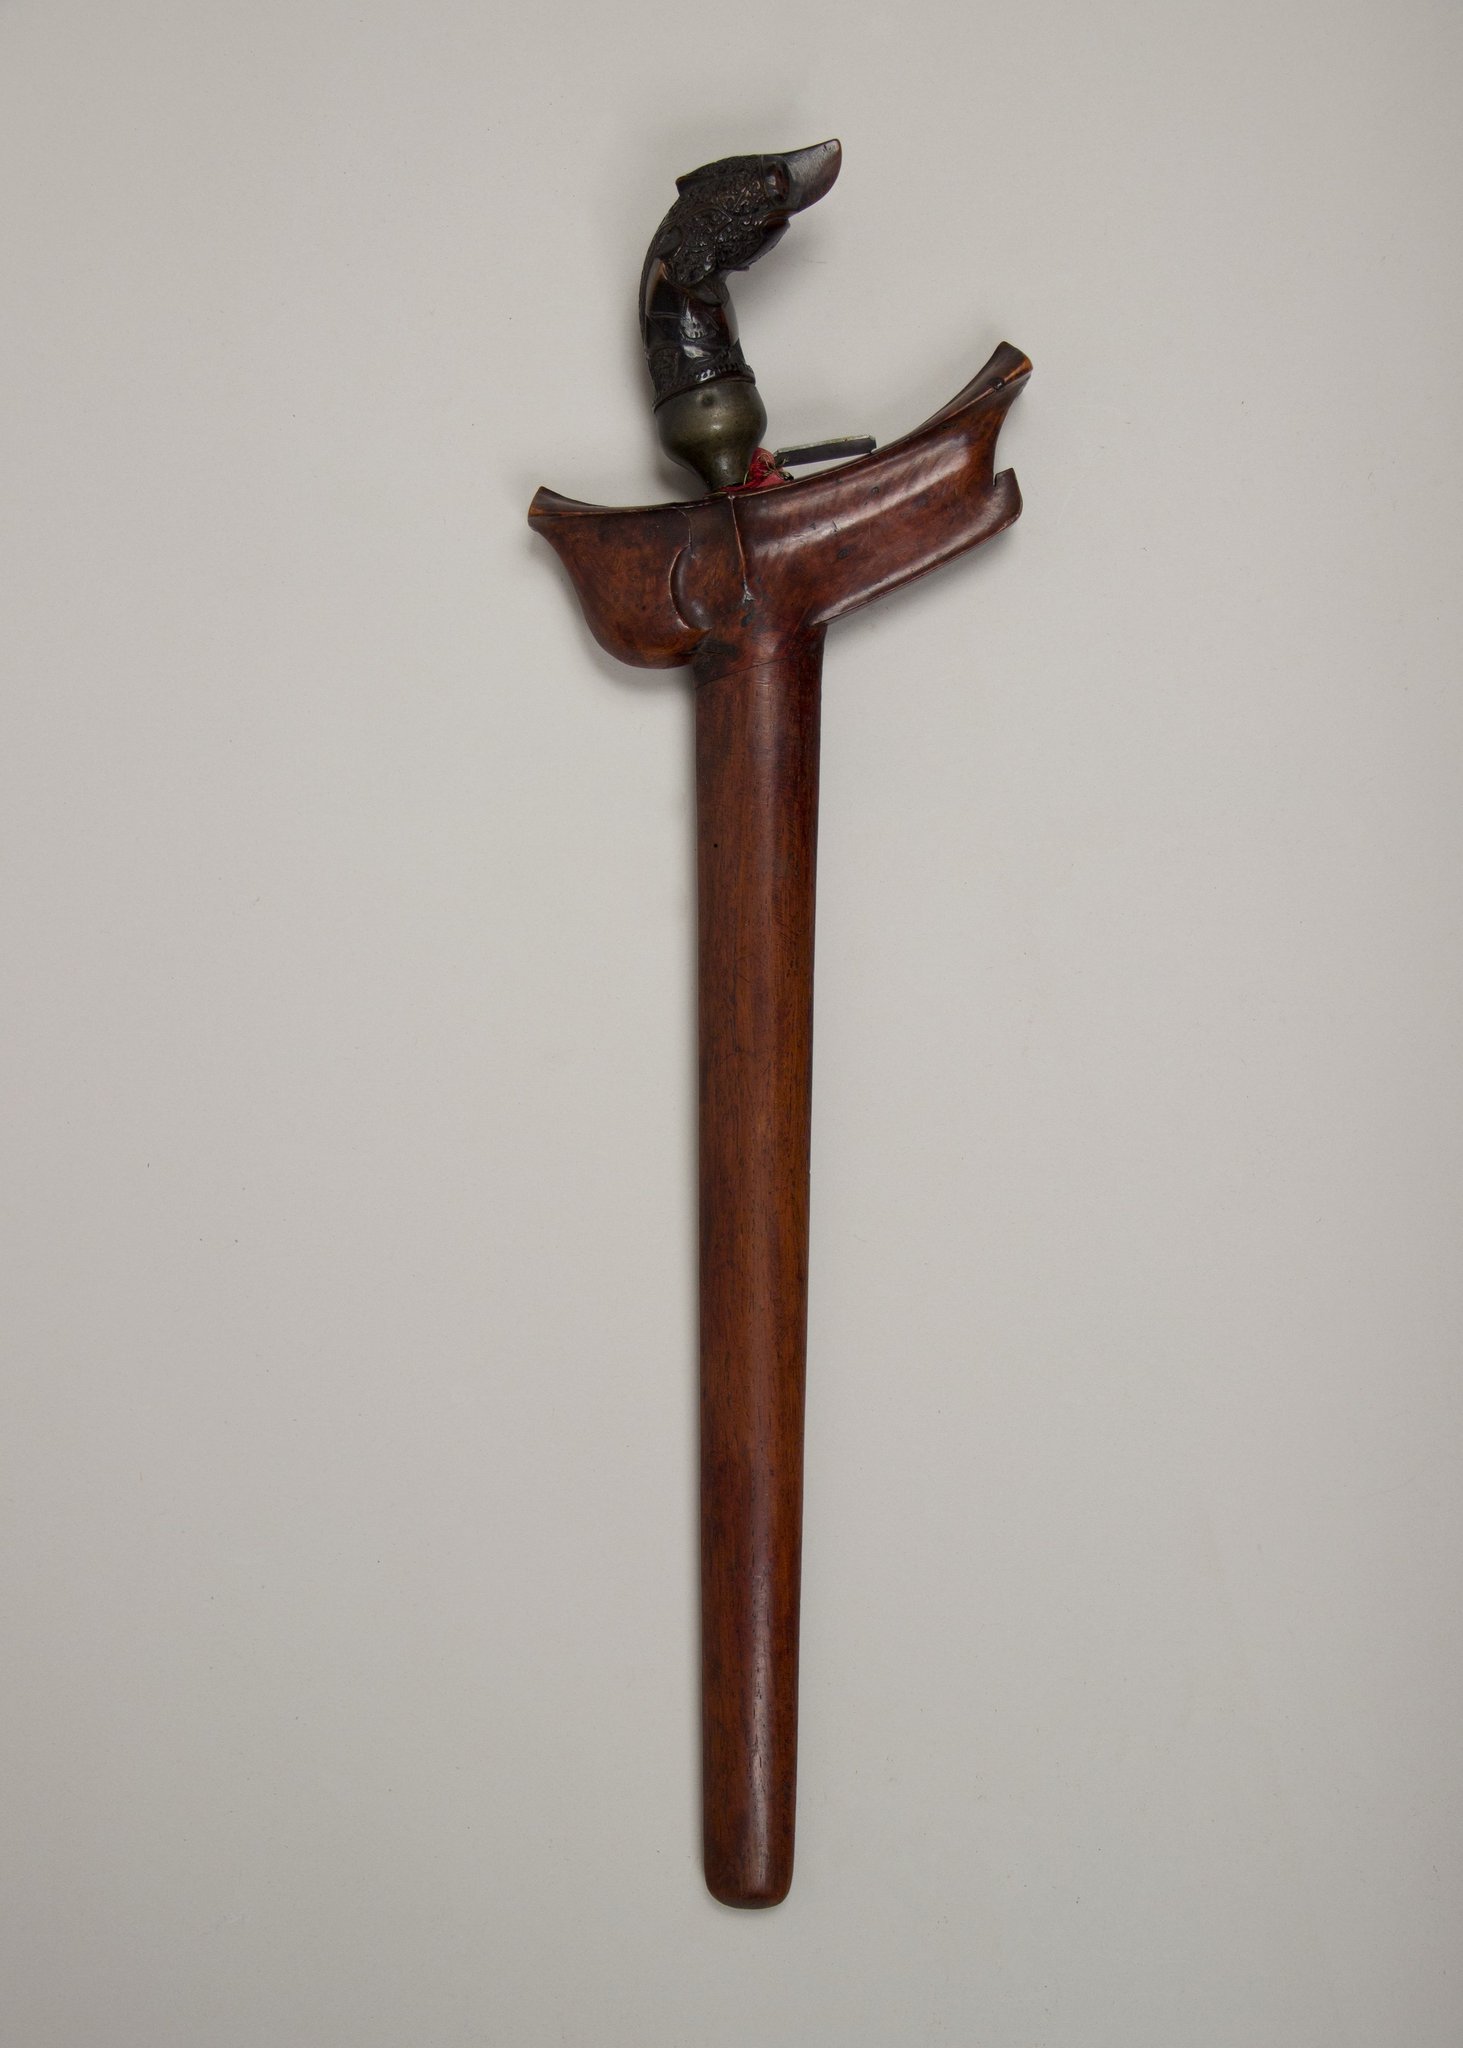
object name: kris with sheath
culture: sumatran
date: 1501-1900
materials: horn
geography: indonesia